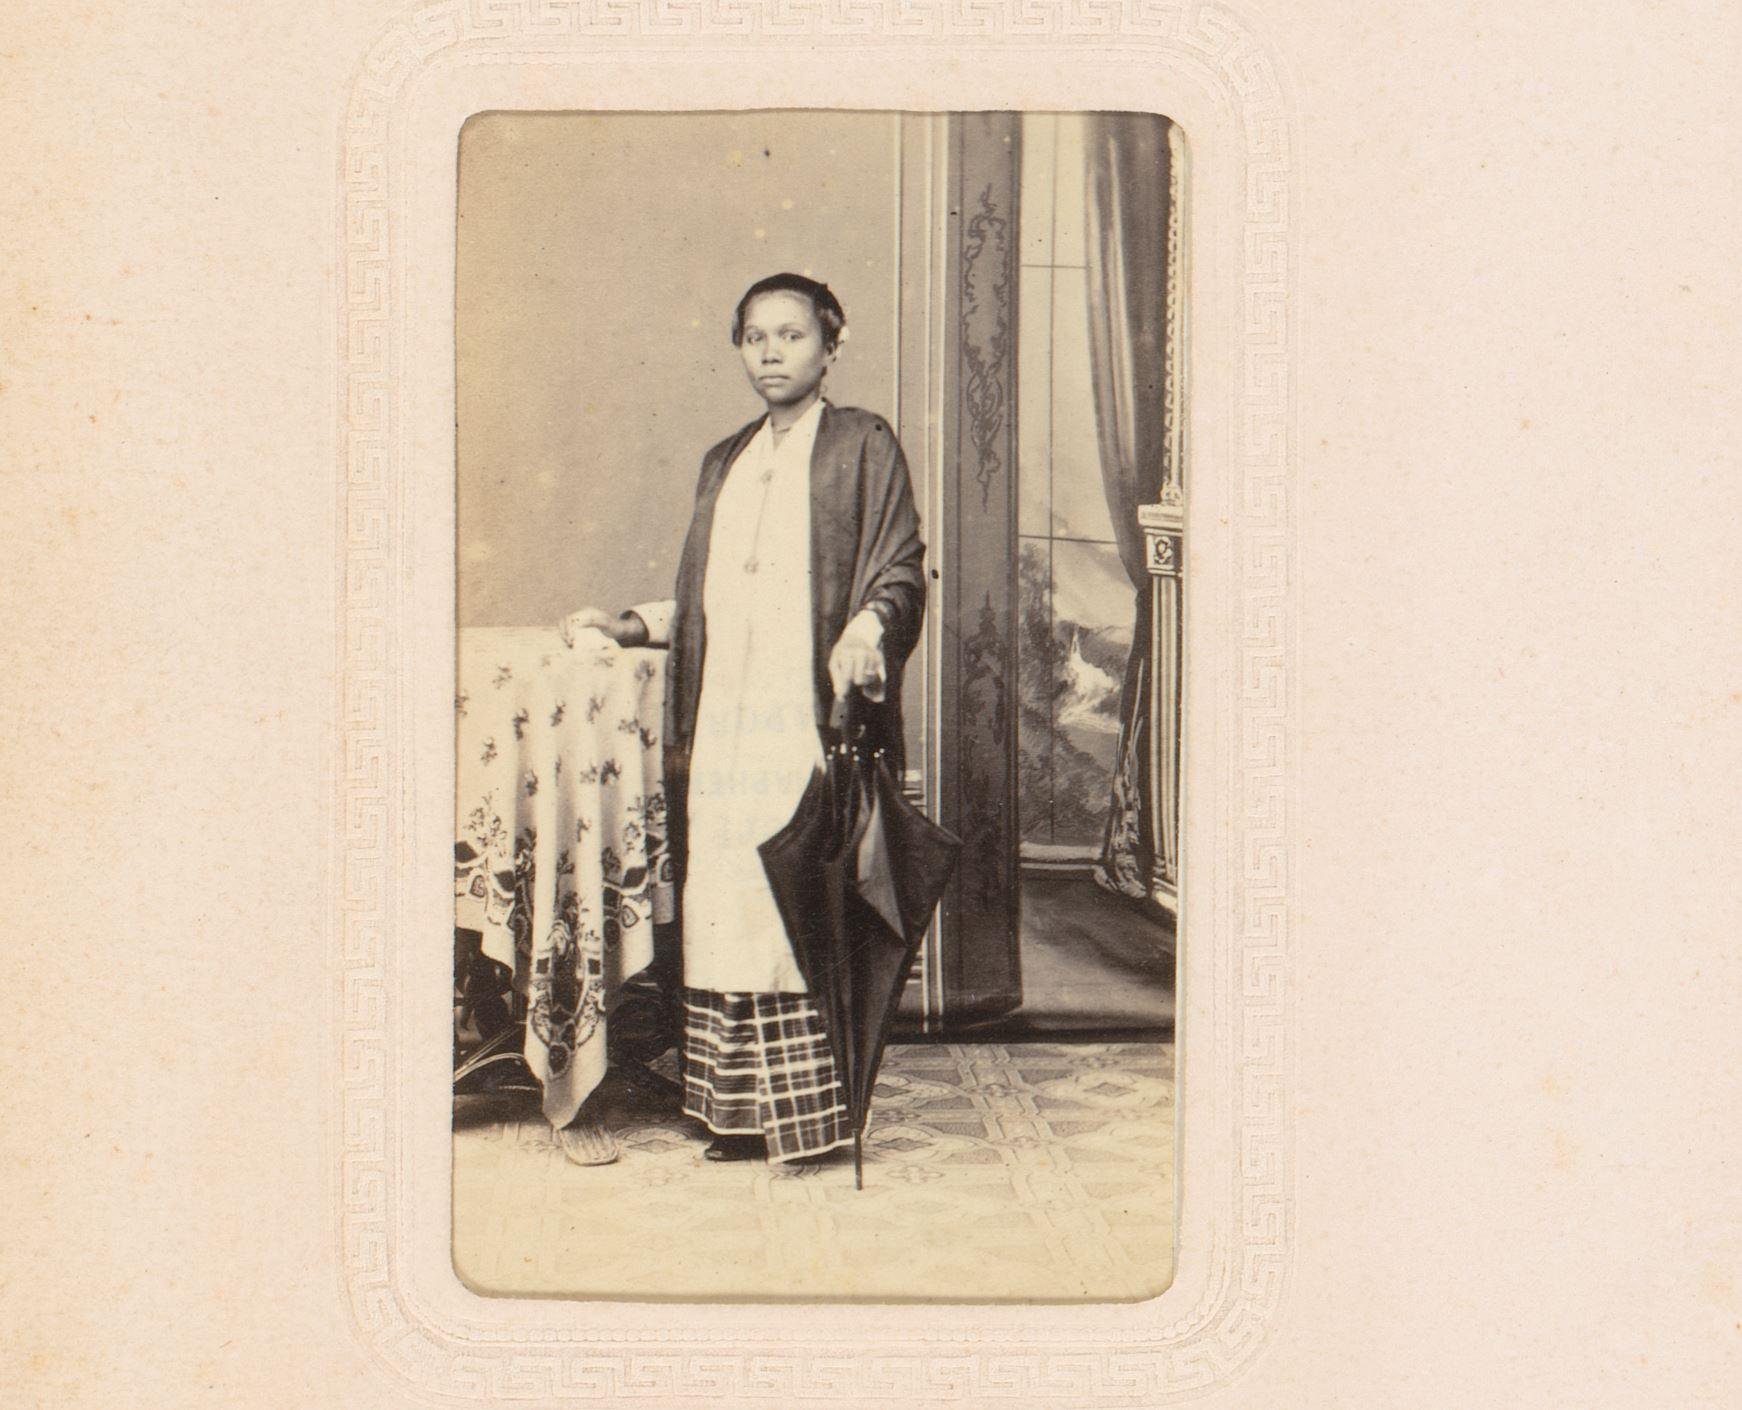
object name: carte de visite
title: Portret van een Maleisische vrouw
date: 1867-1880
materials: cardboard, photographic support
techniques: albumen print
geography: singapore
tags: historical persons - bb - woman, maid ~ house personnel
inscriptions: annotation: ‘1 Malaysche Haushal-terin’, number: ‘18’